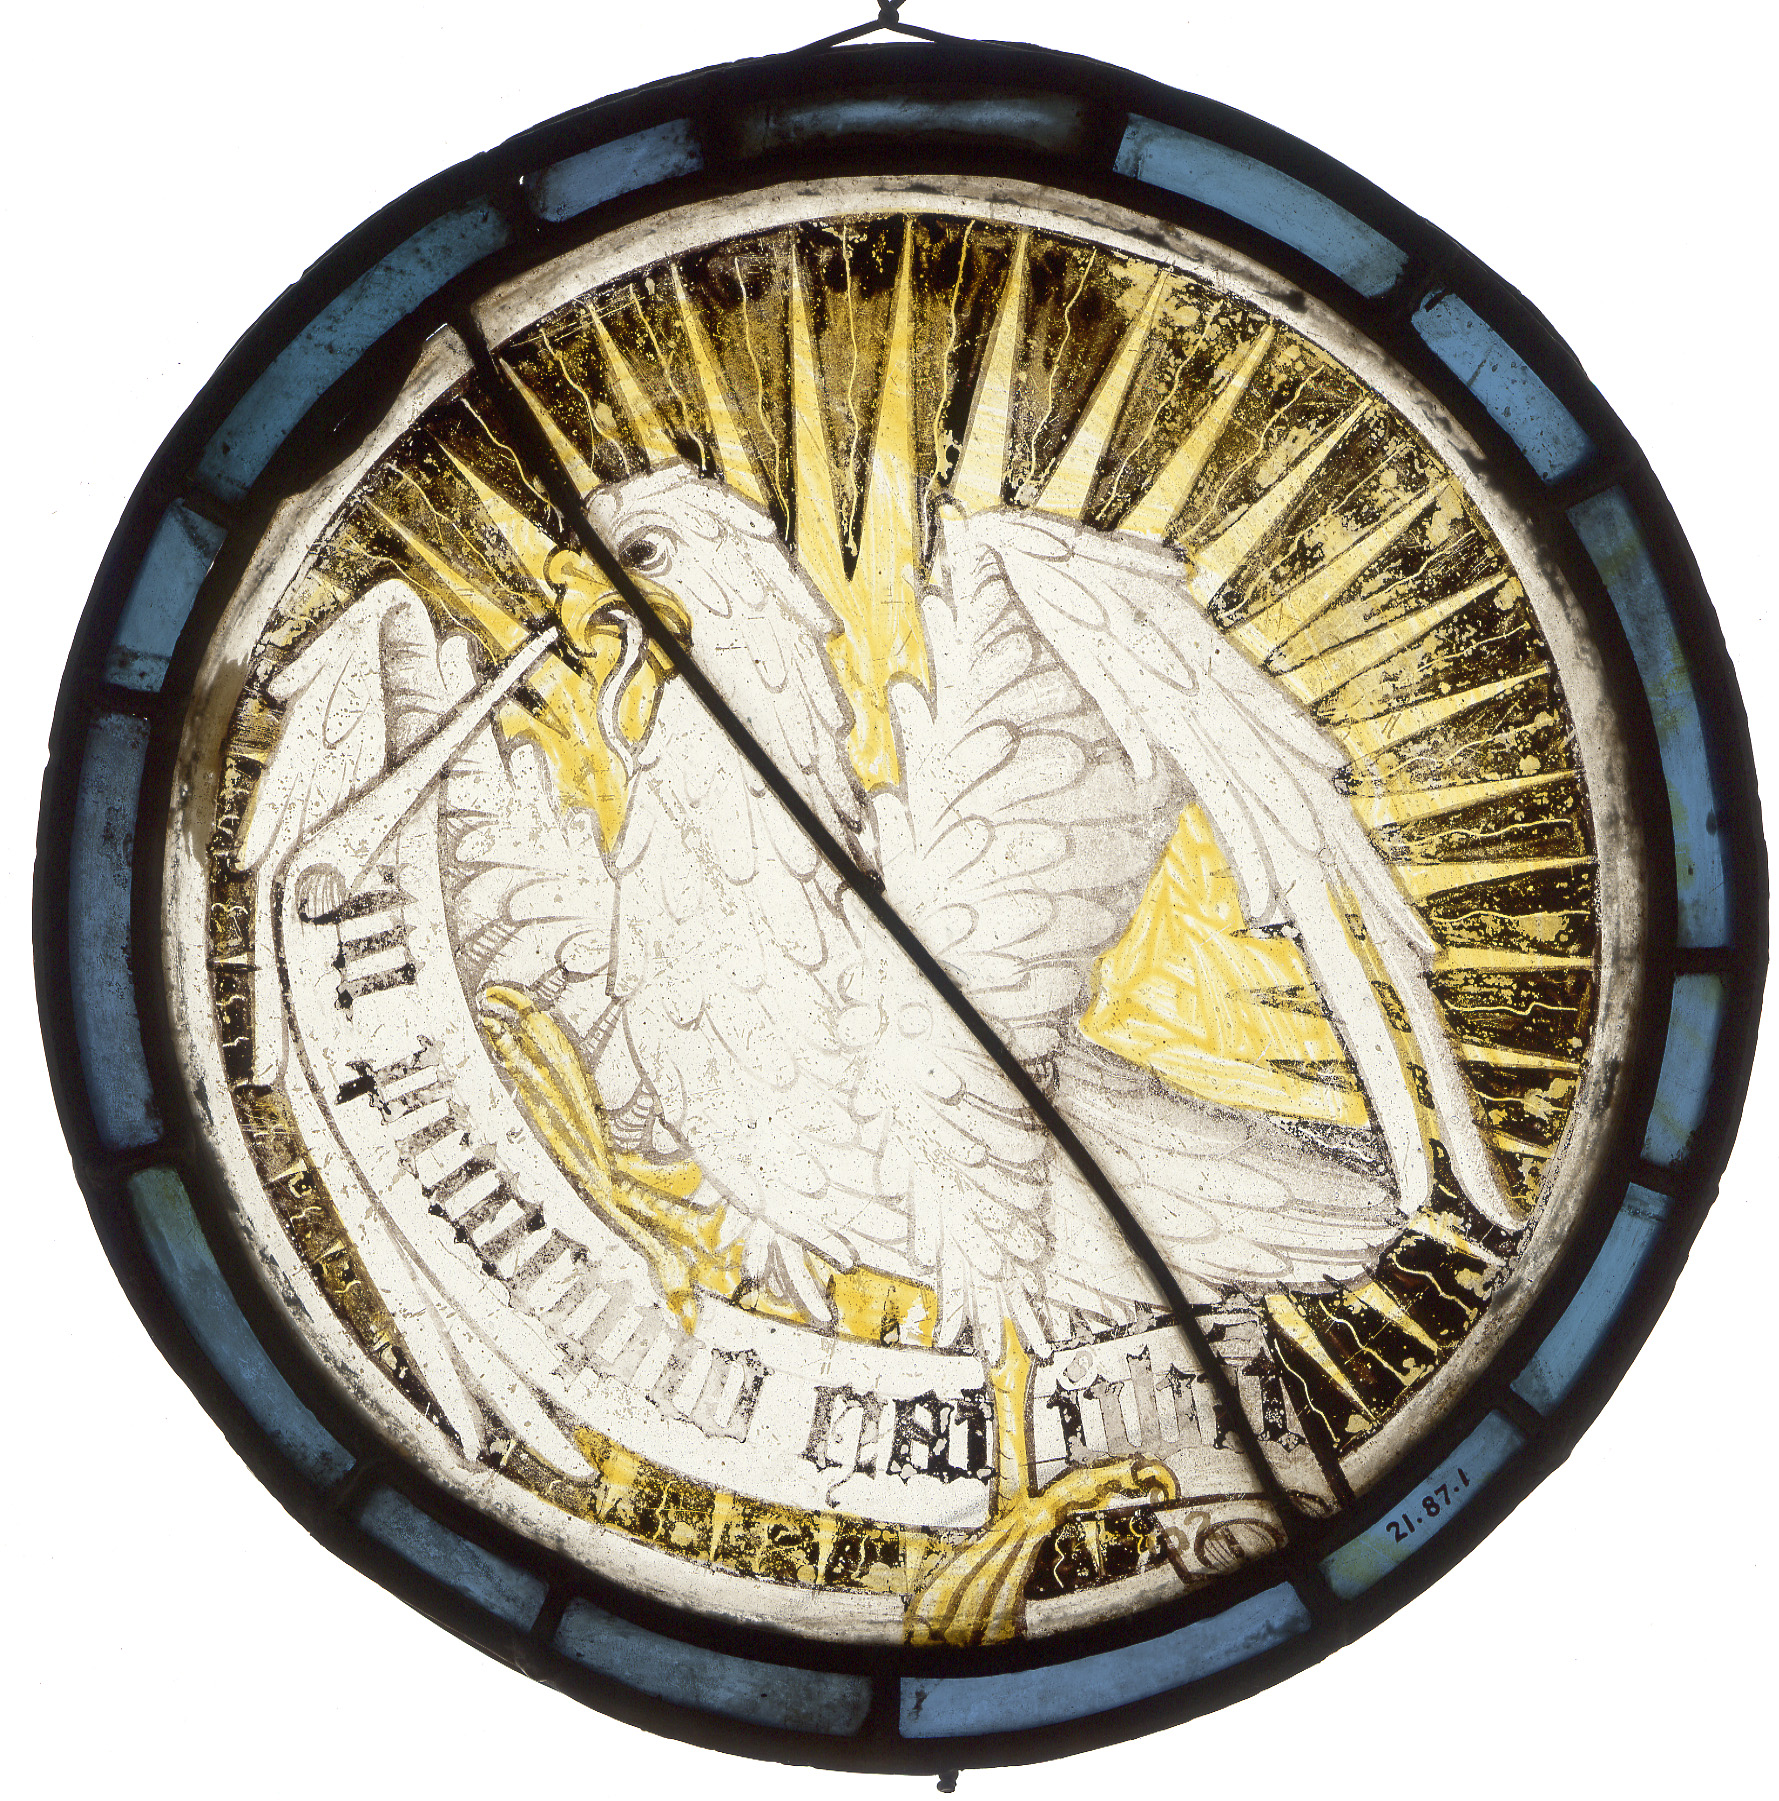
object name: roundel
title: Roundel with an Eagle and Inscription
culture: british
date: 1401-1500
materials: glass, paint, pigment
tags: eagles